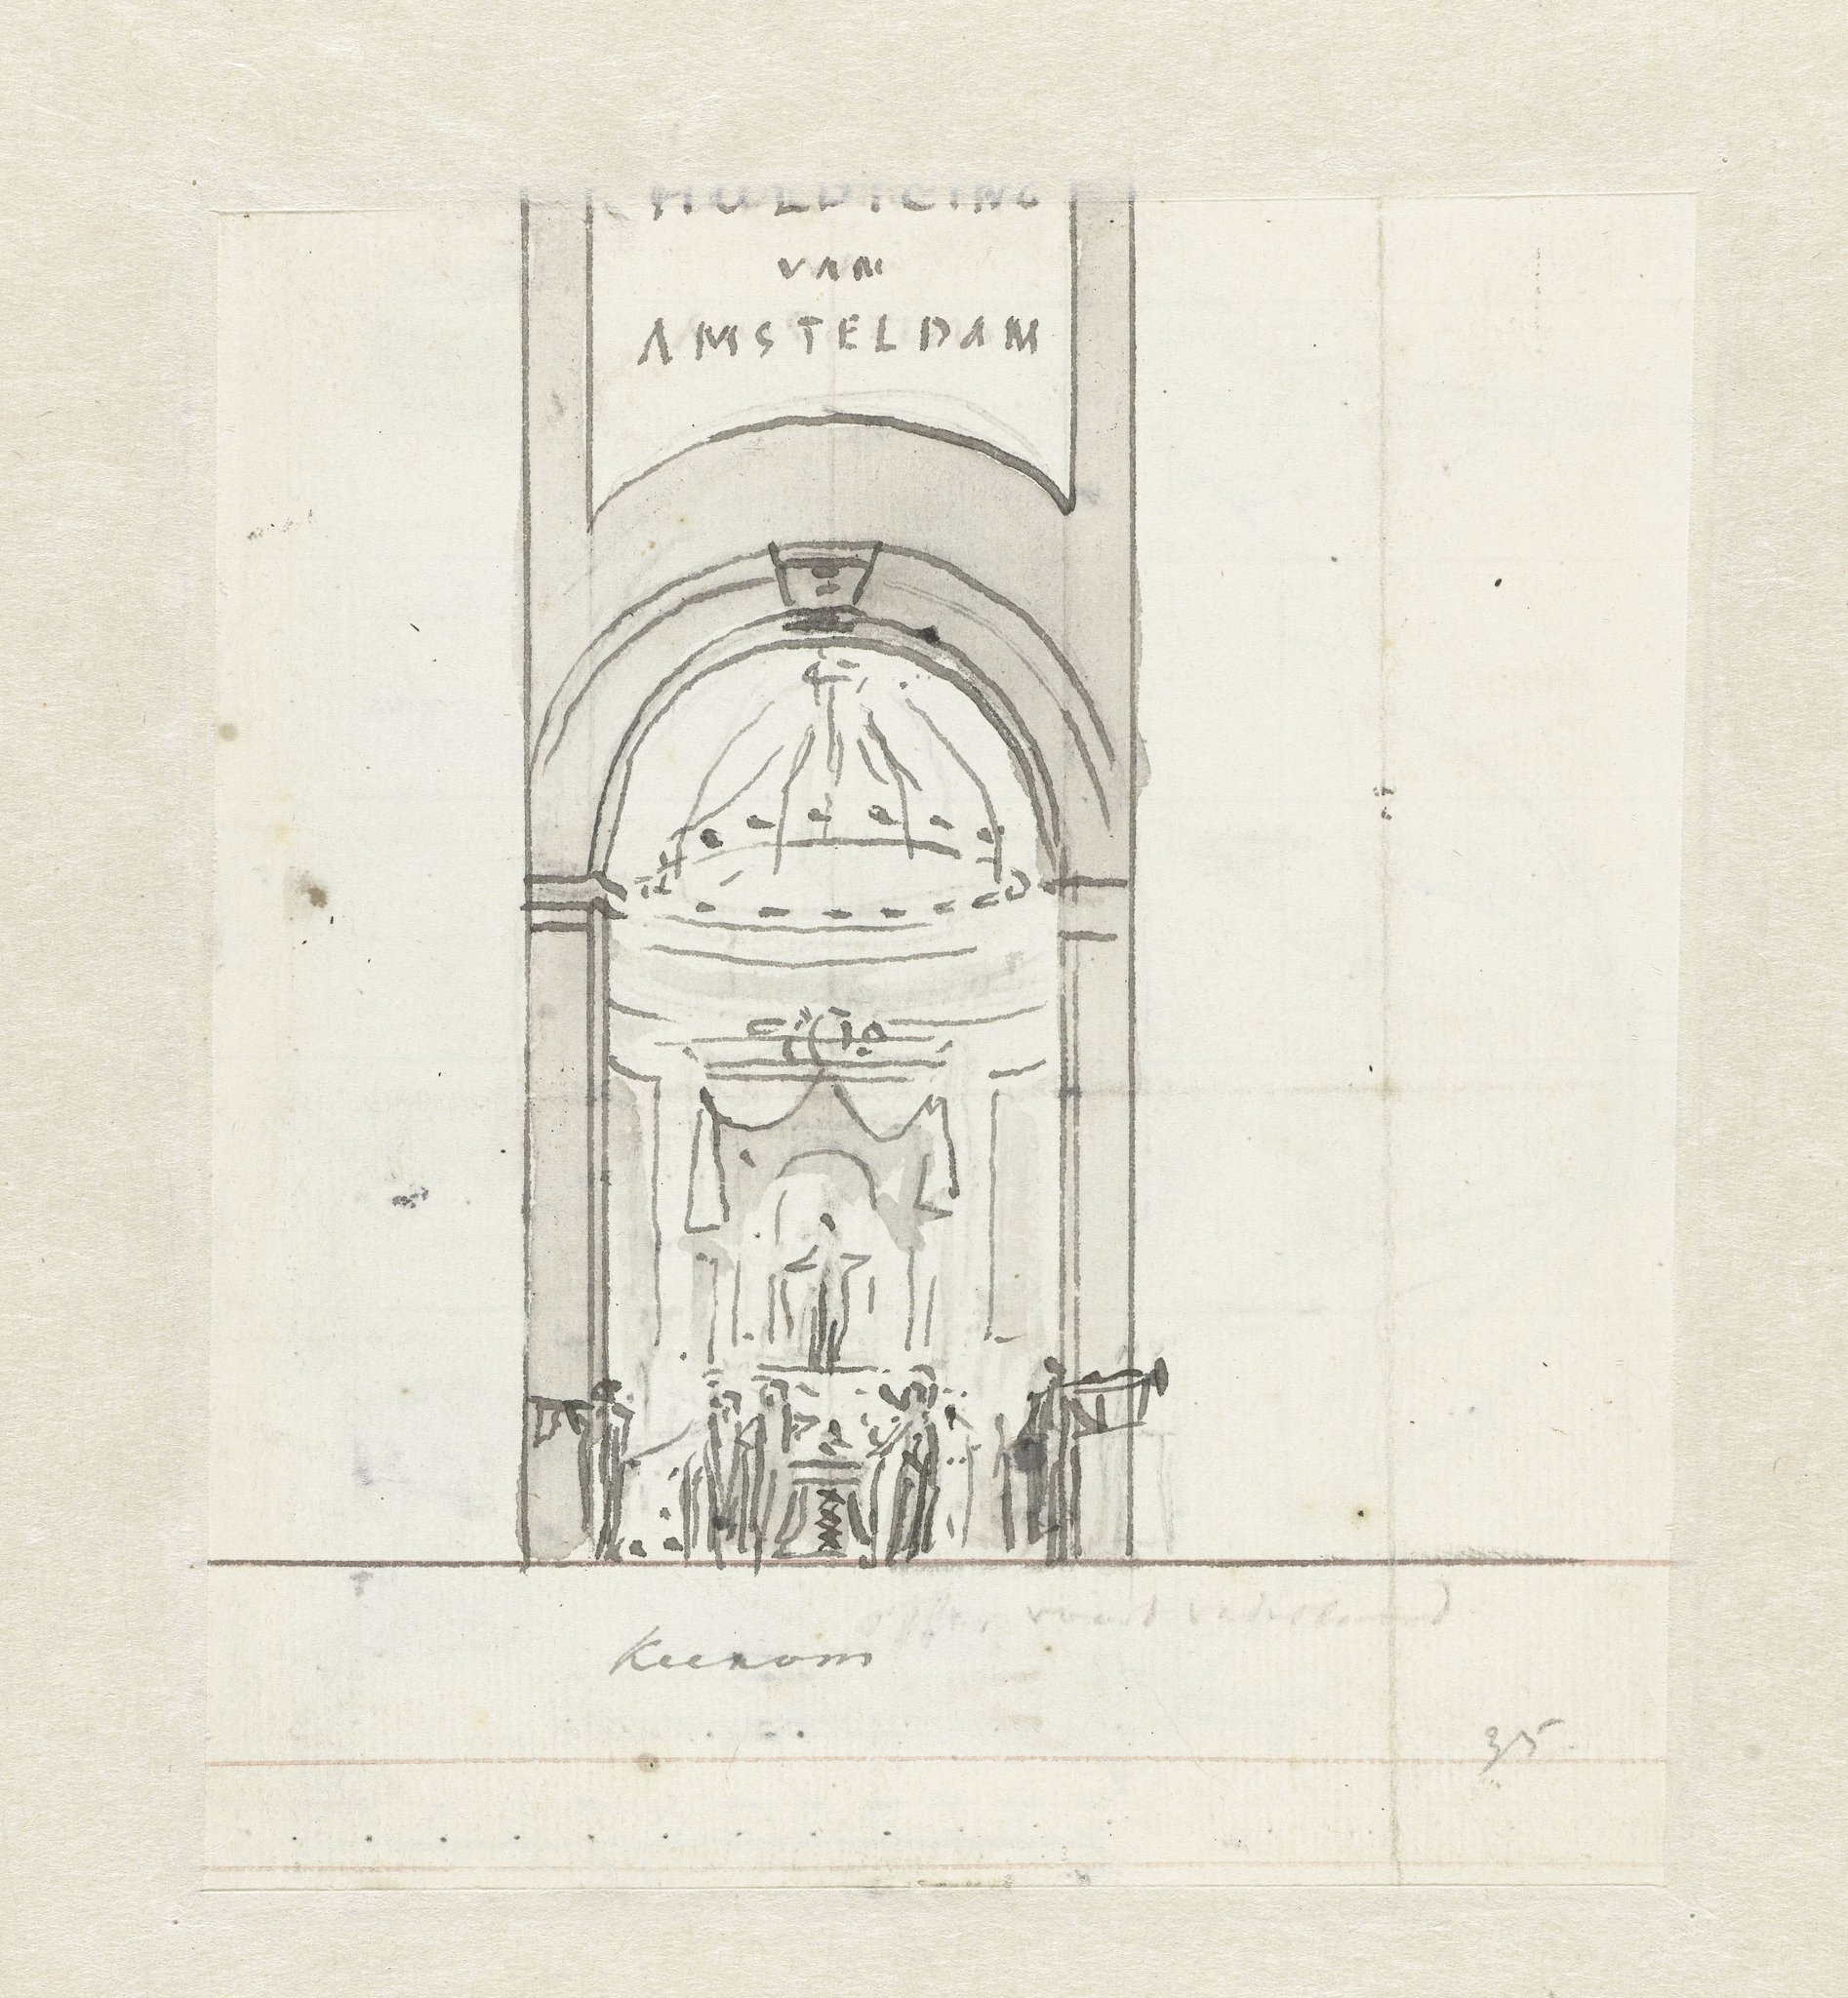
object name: drawing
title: Ontwerp voor decoratie op het gebouw Felix Meritis met Huldiging van Amsterdam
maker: jurriaan andriessen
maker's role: draughtsman, painter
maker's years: 1742-1819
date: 1806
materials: graphite, ink, paper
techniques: brush, pen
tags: historical events and situations, amsterdam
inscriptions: date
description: Detail van een ontwerp voor decoraties op het gebouw Felix Meritis te Amsterdam in 1806: Huldiging van Amsterdam.